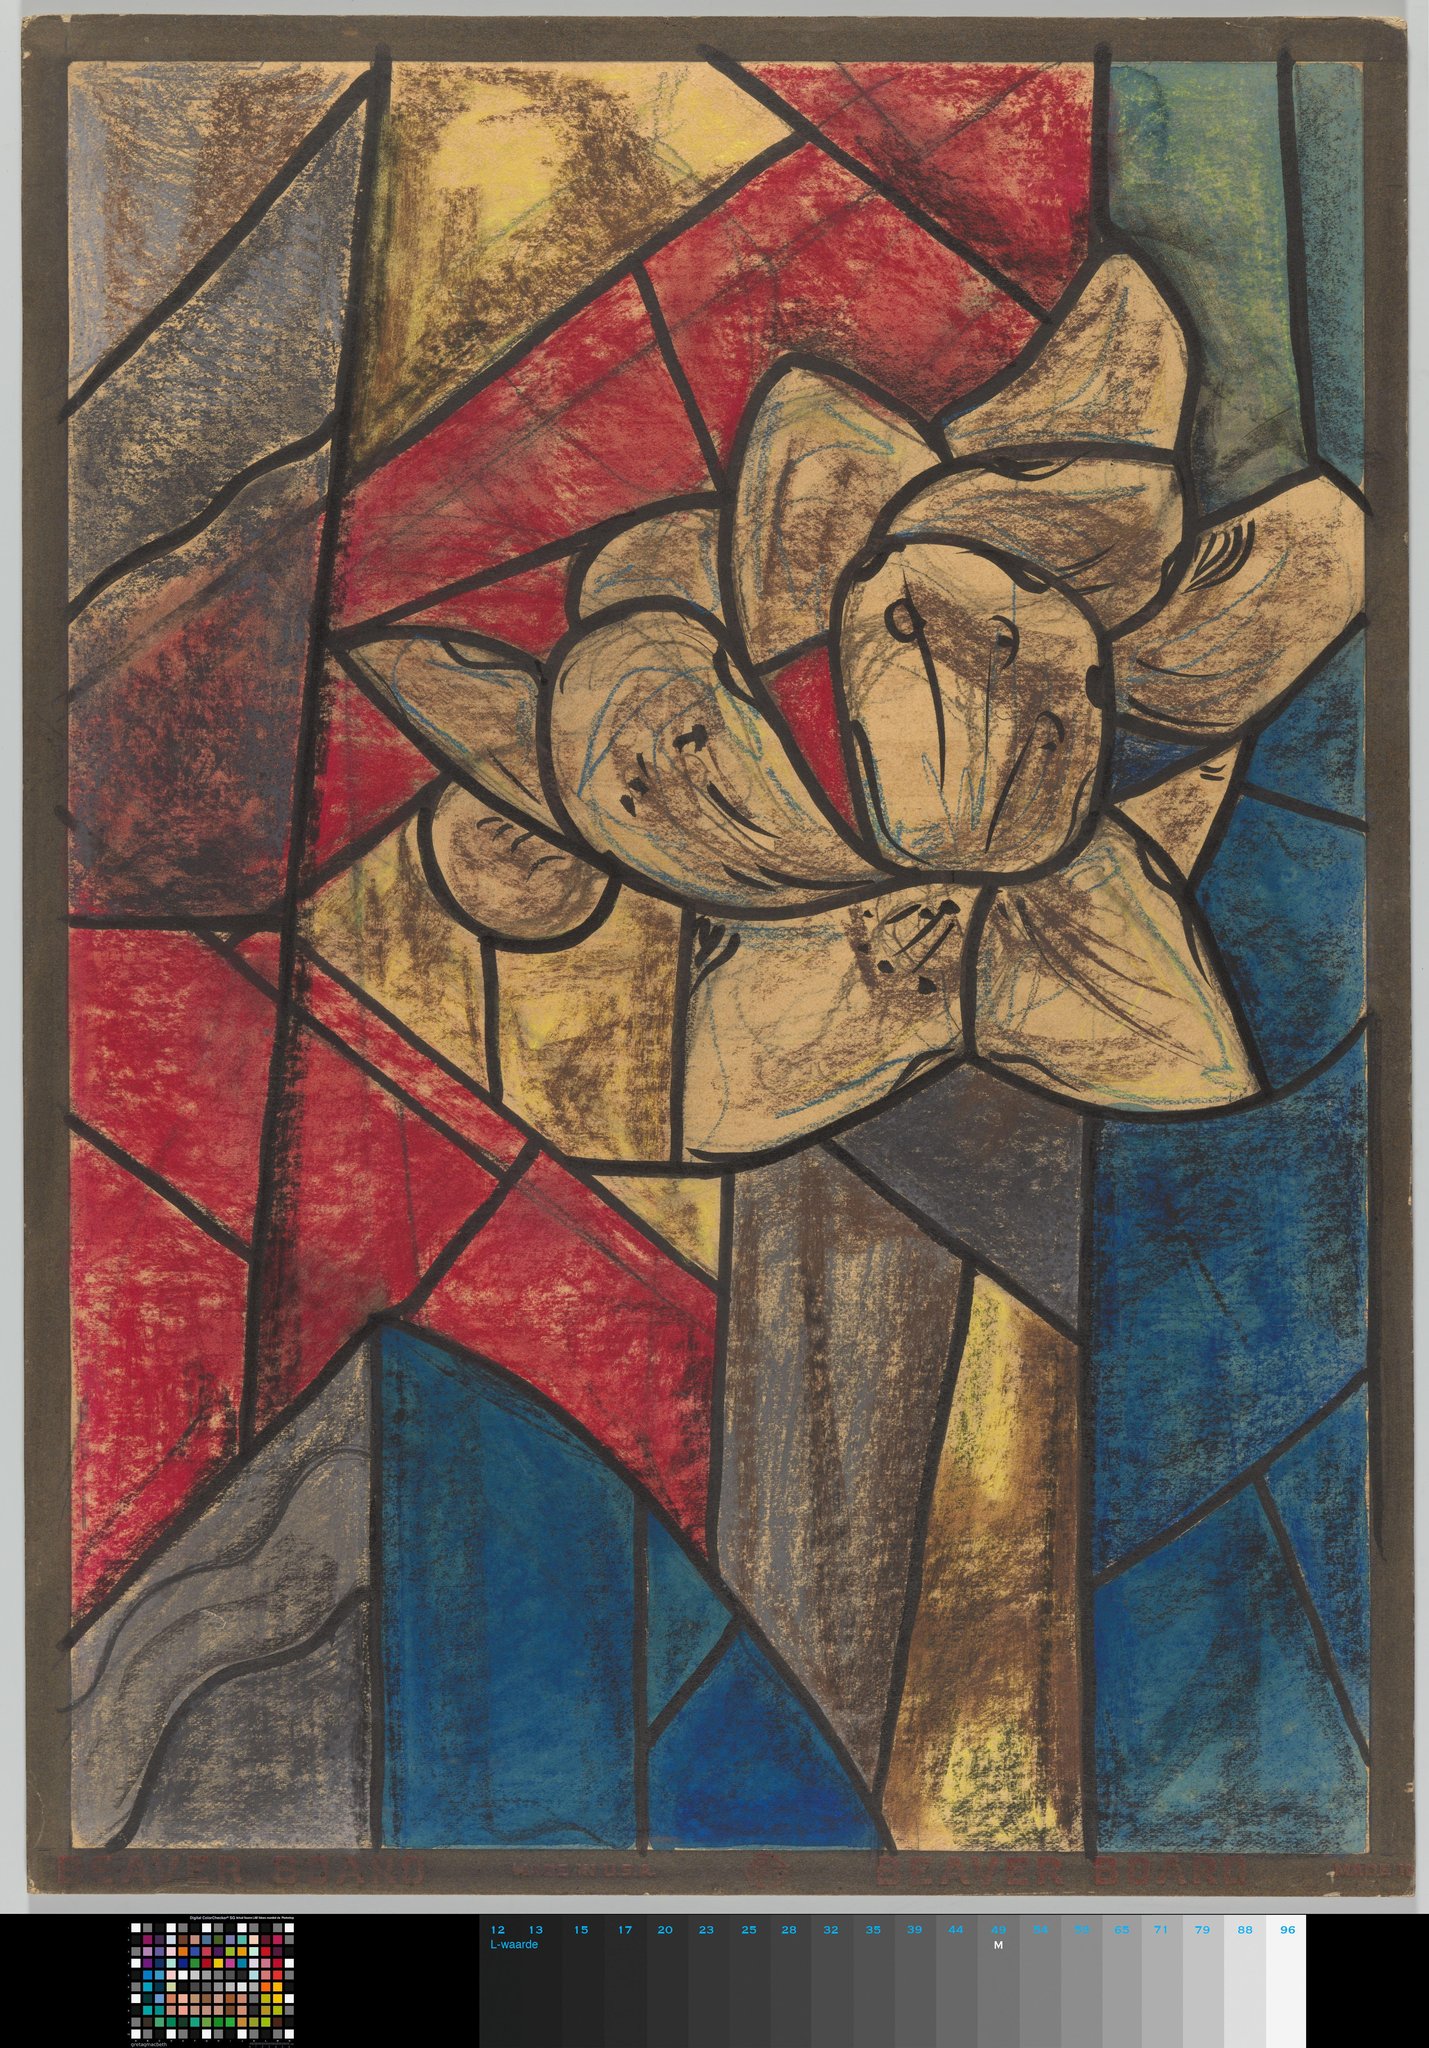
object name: design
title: Ontwerp voor raam in het Noordertransept in de Dom te Utrecht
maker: richard nicolaüs roland holst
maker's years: 1868-1938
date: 1934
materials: cardboard, chalk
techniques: brush